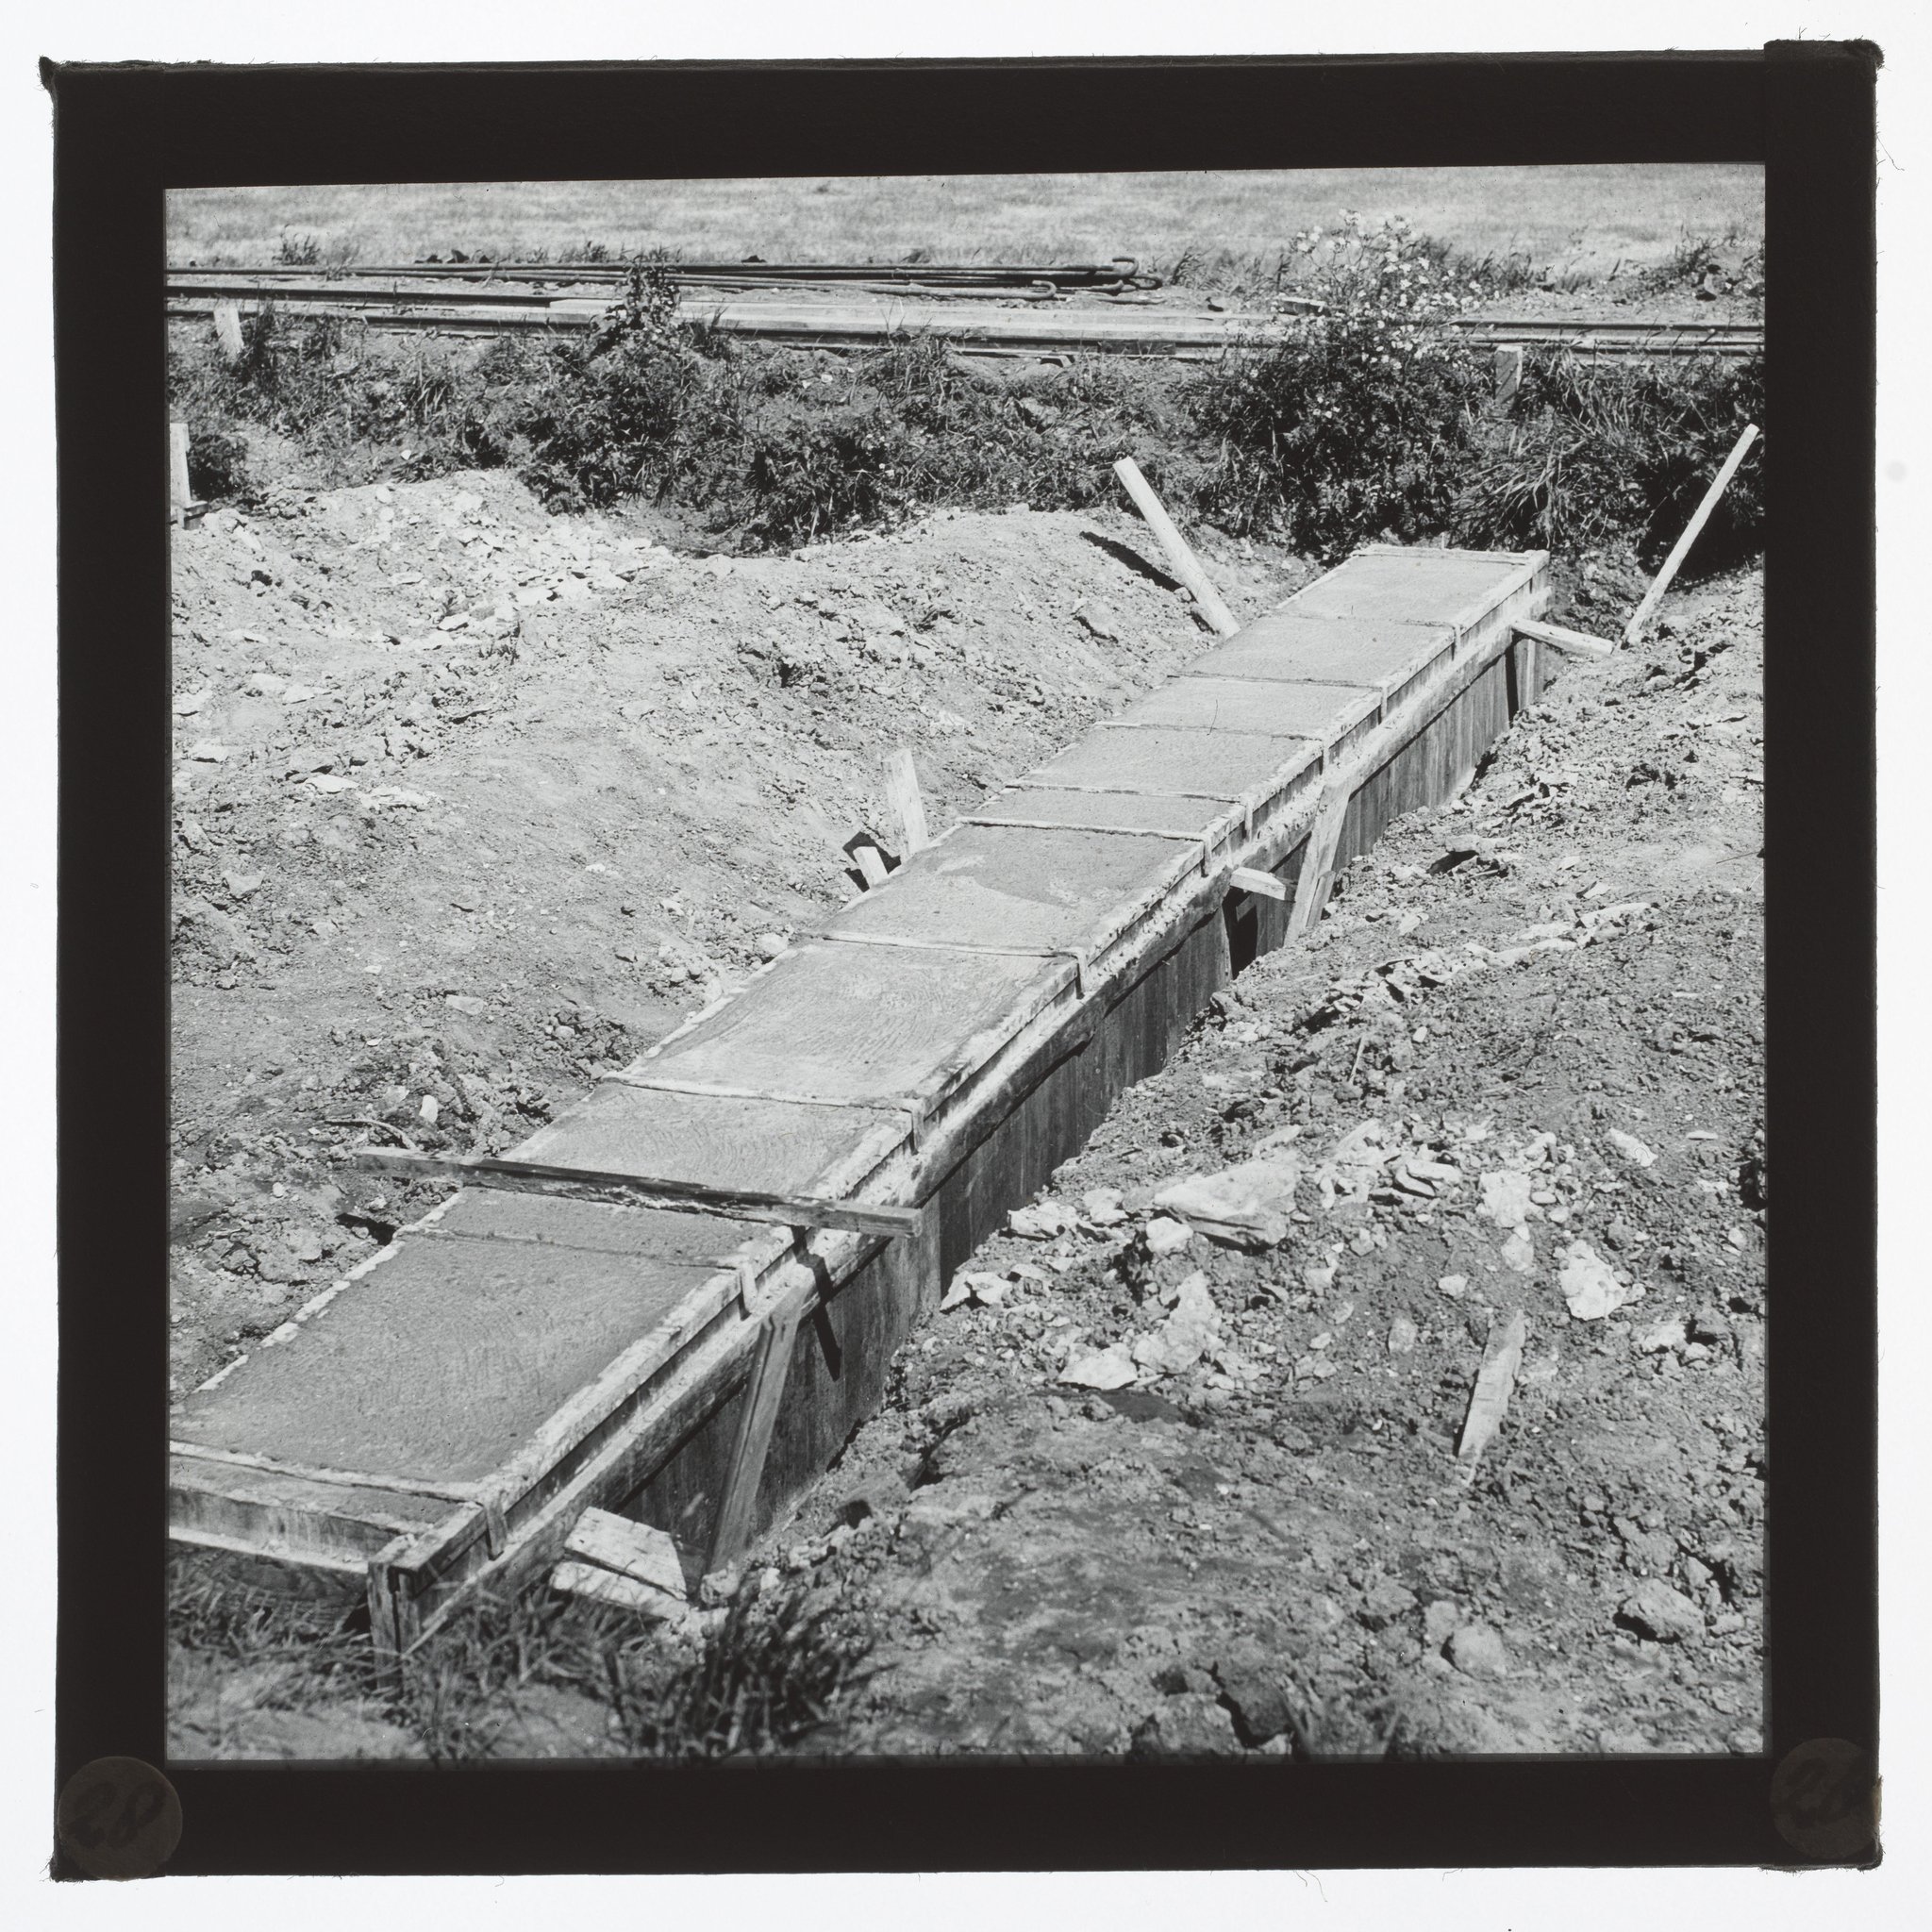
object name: lantern slide photographic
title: Bouwplaats, Zuid-Holland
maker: Anonymous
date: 1956-1960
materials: glass, paper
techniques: gelatin silver transparency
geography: south holland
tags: building-site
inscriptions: number: ‘28’